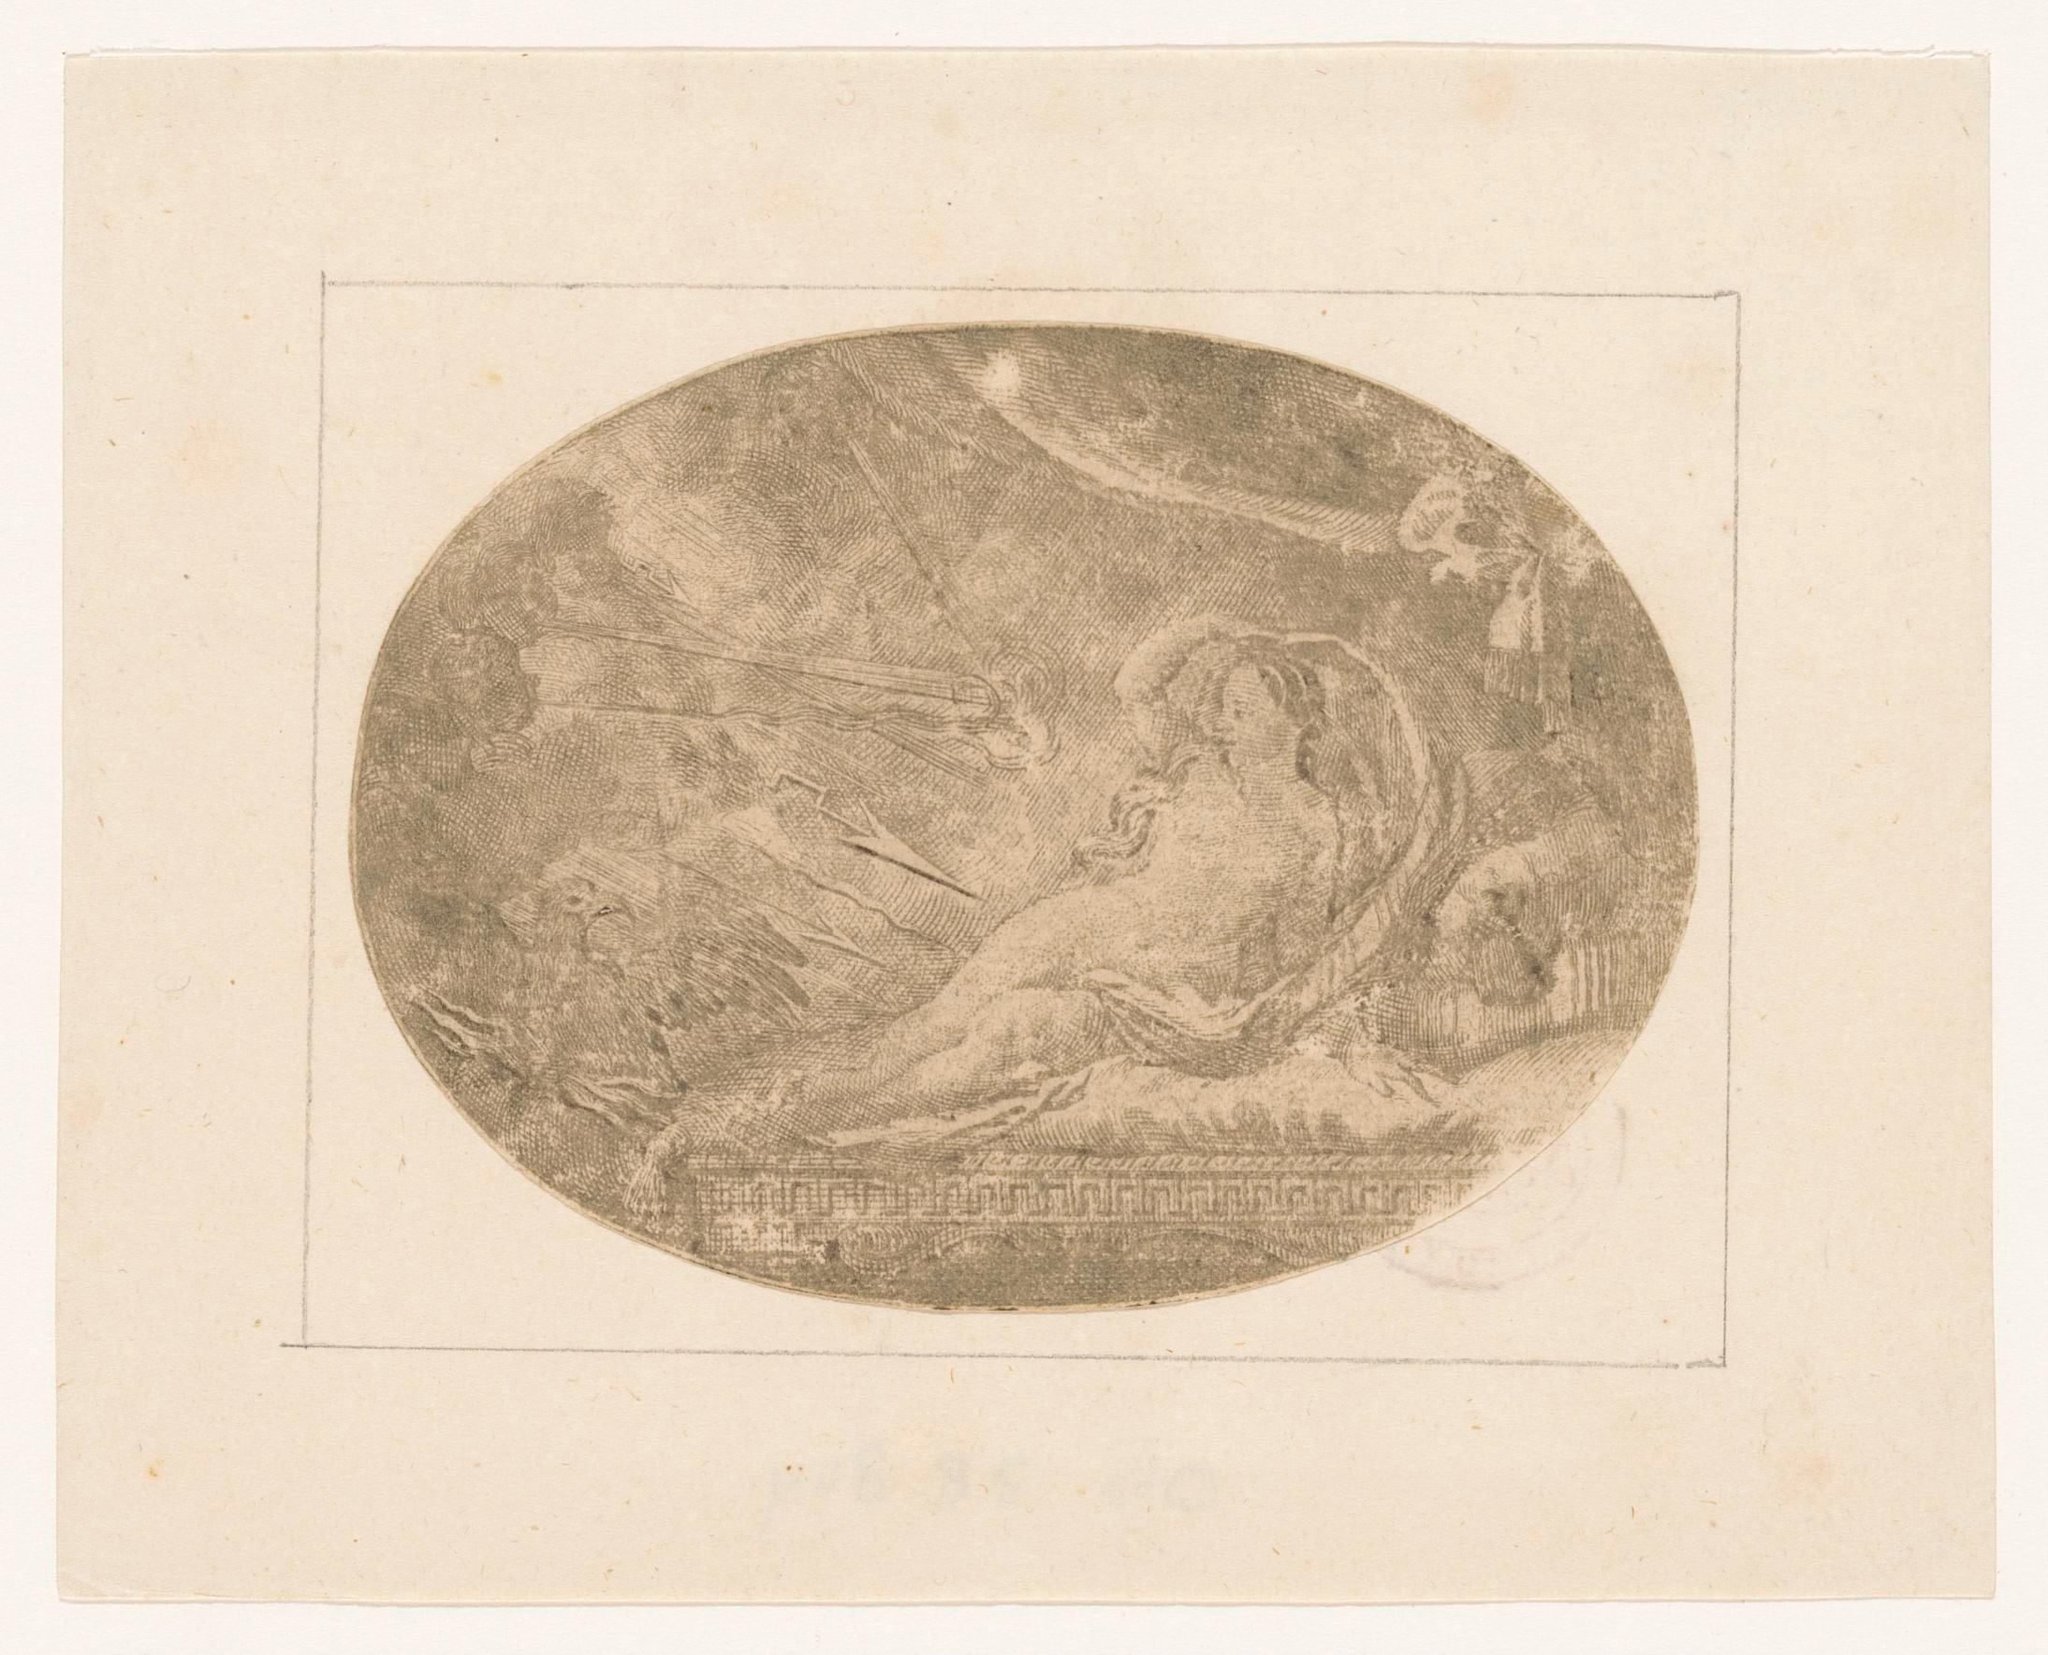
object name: print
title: Vrouw wordt bezocht door Jupiter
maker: Anonymous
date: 1500-1599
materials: paper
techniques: printing, engraving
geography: italy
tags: (story of) jupiter (zeus), woman (showing herself) undressed, quasi-nude, winds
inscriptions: collector's mark: Lugt 240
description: Een naakte vrouw liggend op een bed. Links komen de adelaar en bliksemschichten van Jupiter op haar af, terwijl de vier winden met bolle wangen wind uitblazen.